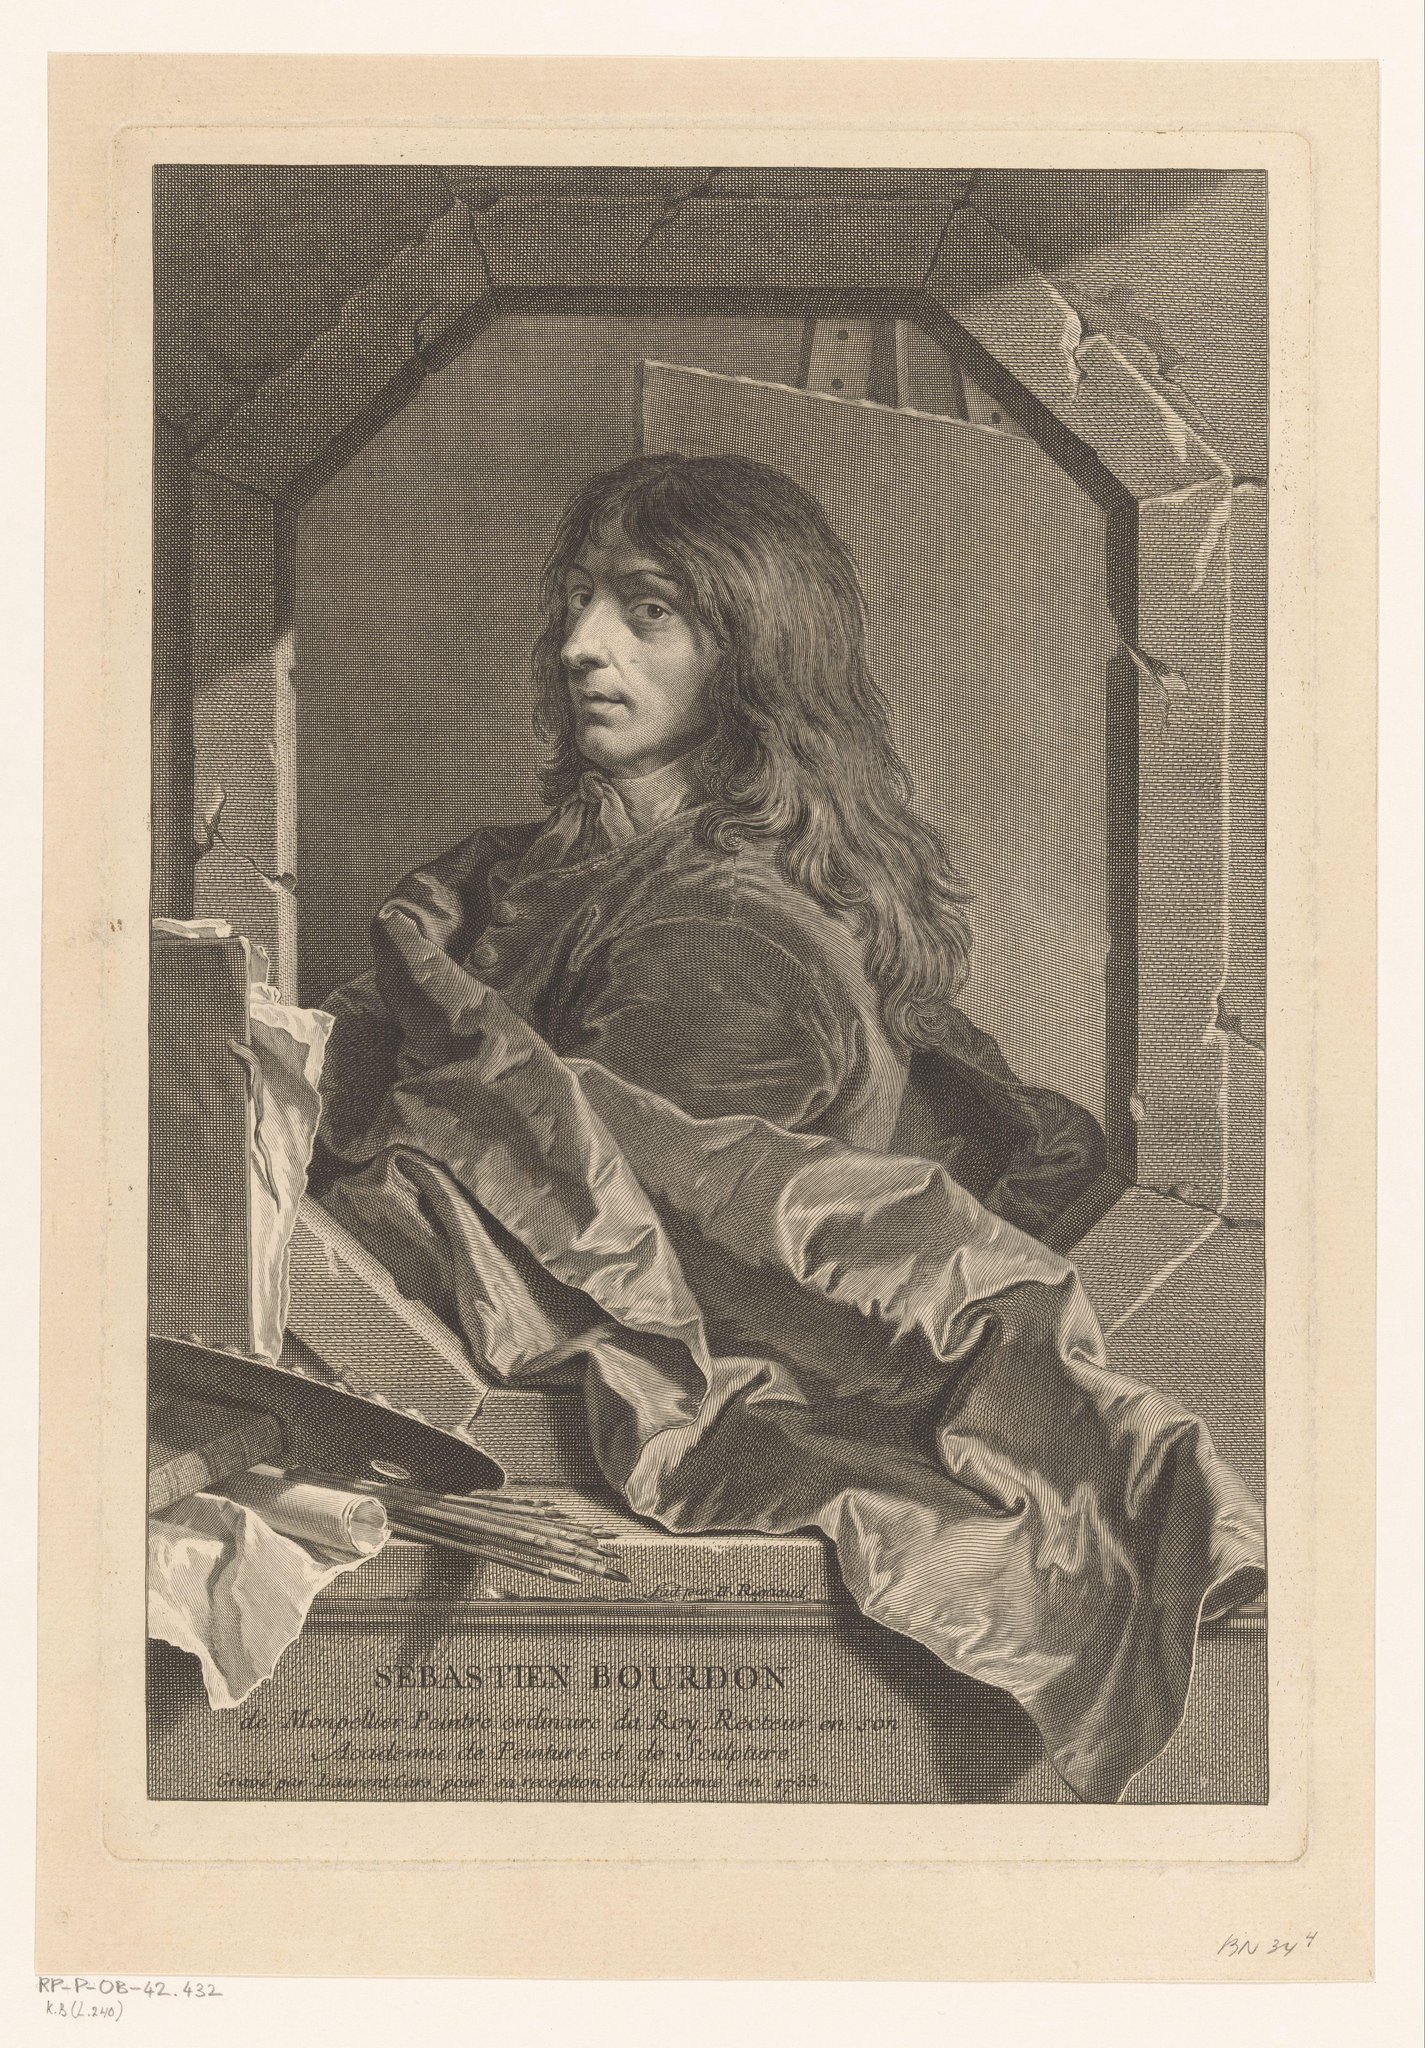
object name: print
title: Portret van Sébastien Bourdon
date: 1733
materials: paper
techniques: engraving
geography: france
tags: paris, painter, draughtsman, sébastien bourdon, historical persons, portrait, self-portrait of painter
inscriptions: collector's mark: Lugt 240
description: Vervaardigd voor zijn toetreden tot de Académie Royale op 31 december 1733, evenals het portret van Michel Anguier naar Gabriel Revel (RP-P-1921-1703).